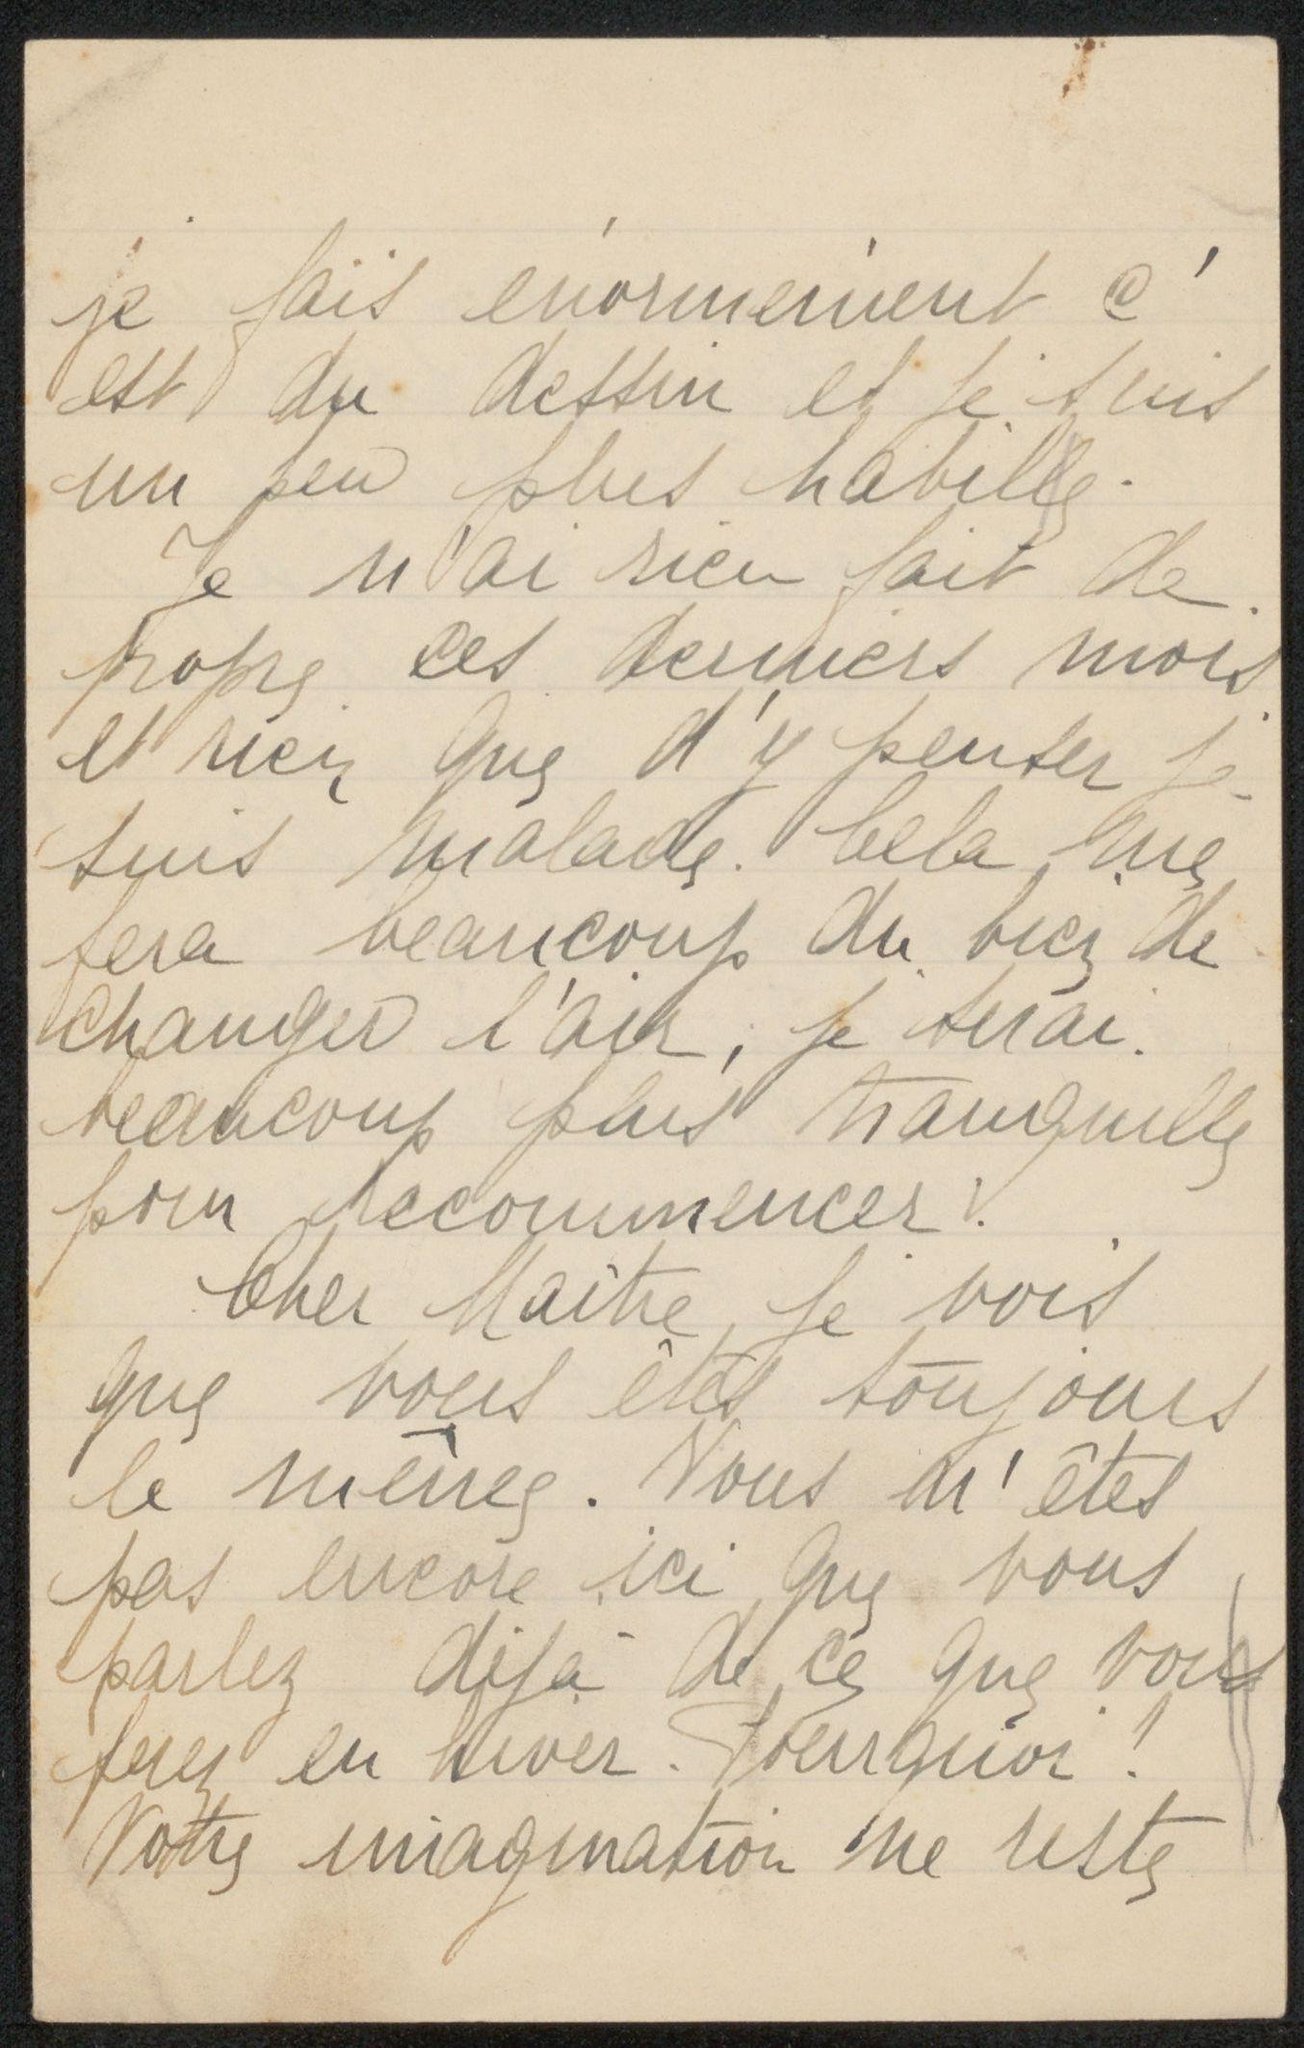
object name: letter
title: Brief aan Philip Zilcken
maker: rose imel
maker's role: draughtsman, painter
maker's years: 1901-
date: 1911-1930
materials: ink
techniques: pen, writing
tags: paris, painter, print maker, draughtsman, sculptor, edgar degas, the hague, philip zilcken, drawing, workshop, studio of the artist (in general), exhibition ~ art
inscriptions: collector's mark: ‘RPK’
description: Betreft een deel van een brief (zonder aanhef) dat bewaard is bij correspondentie van Rose Imel aan Philip Zilcken.